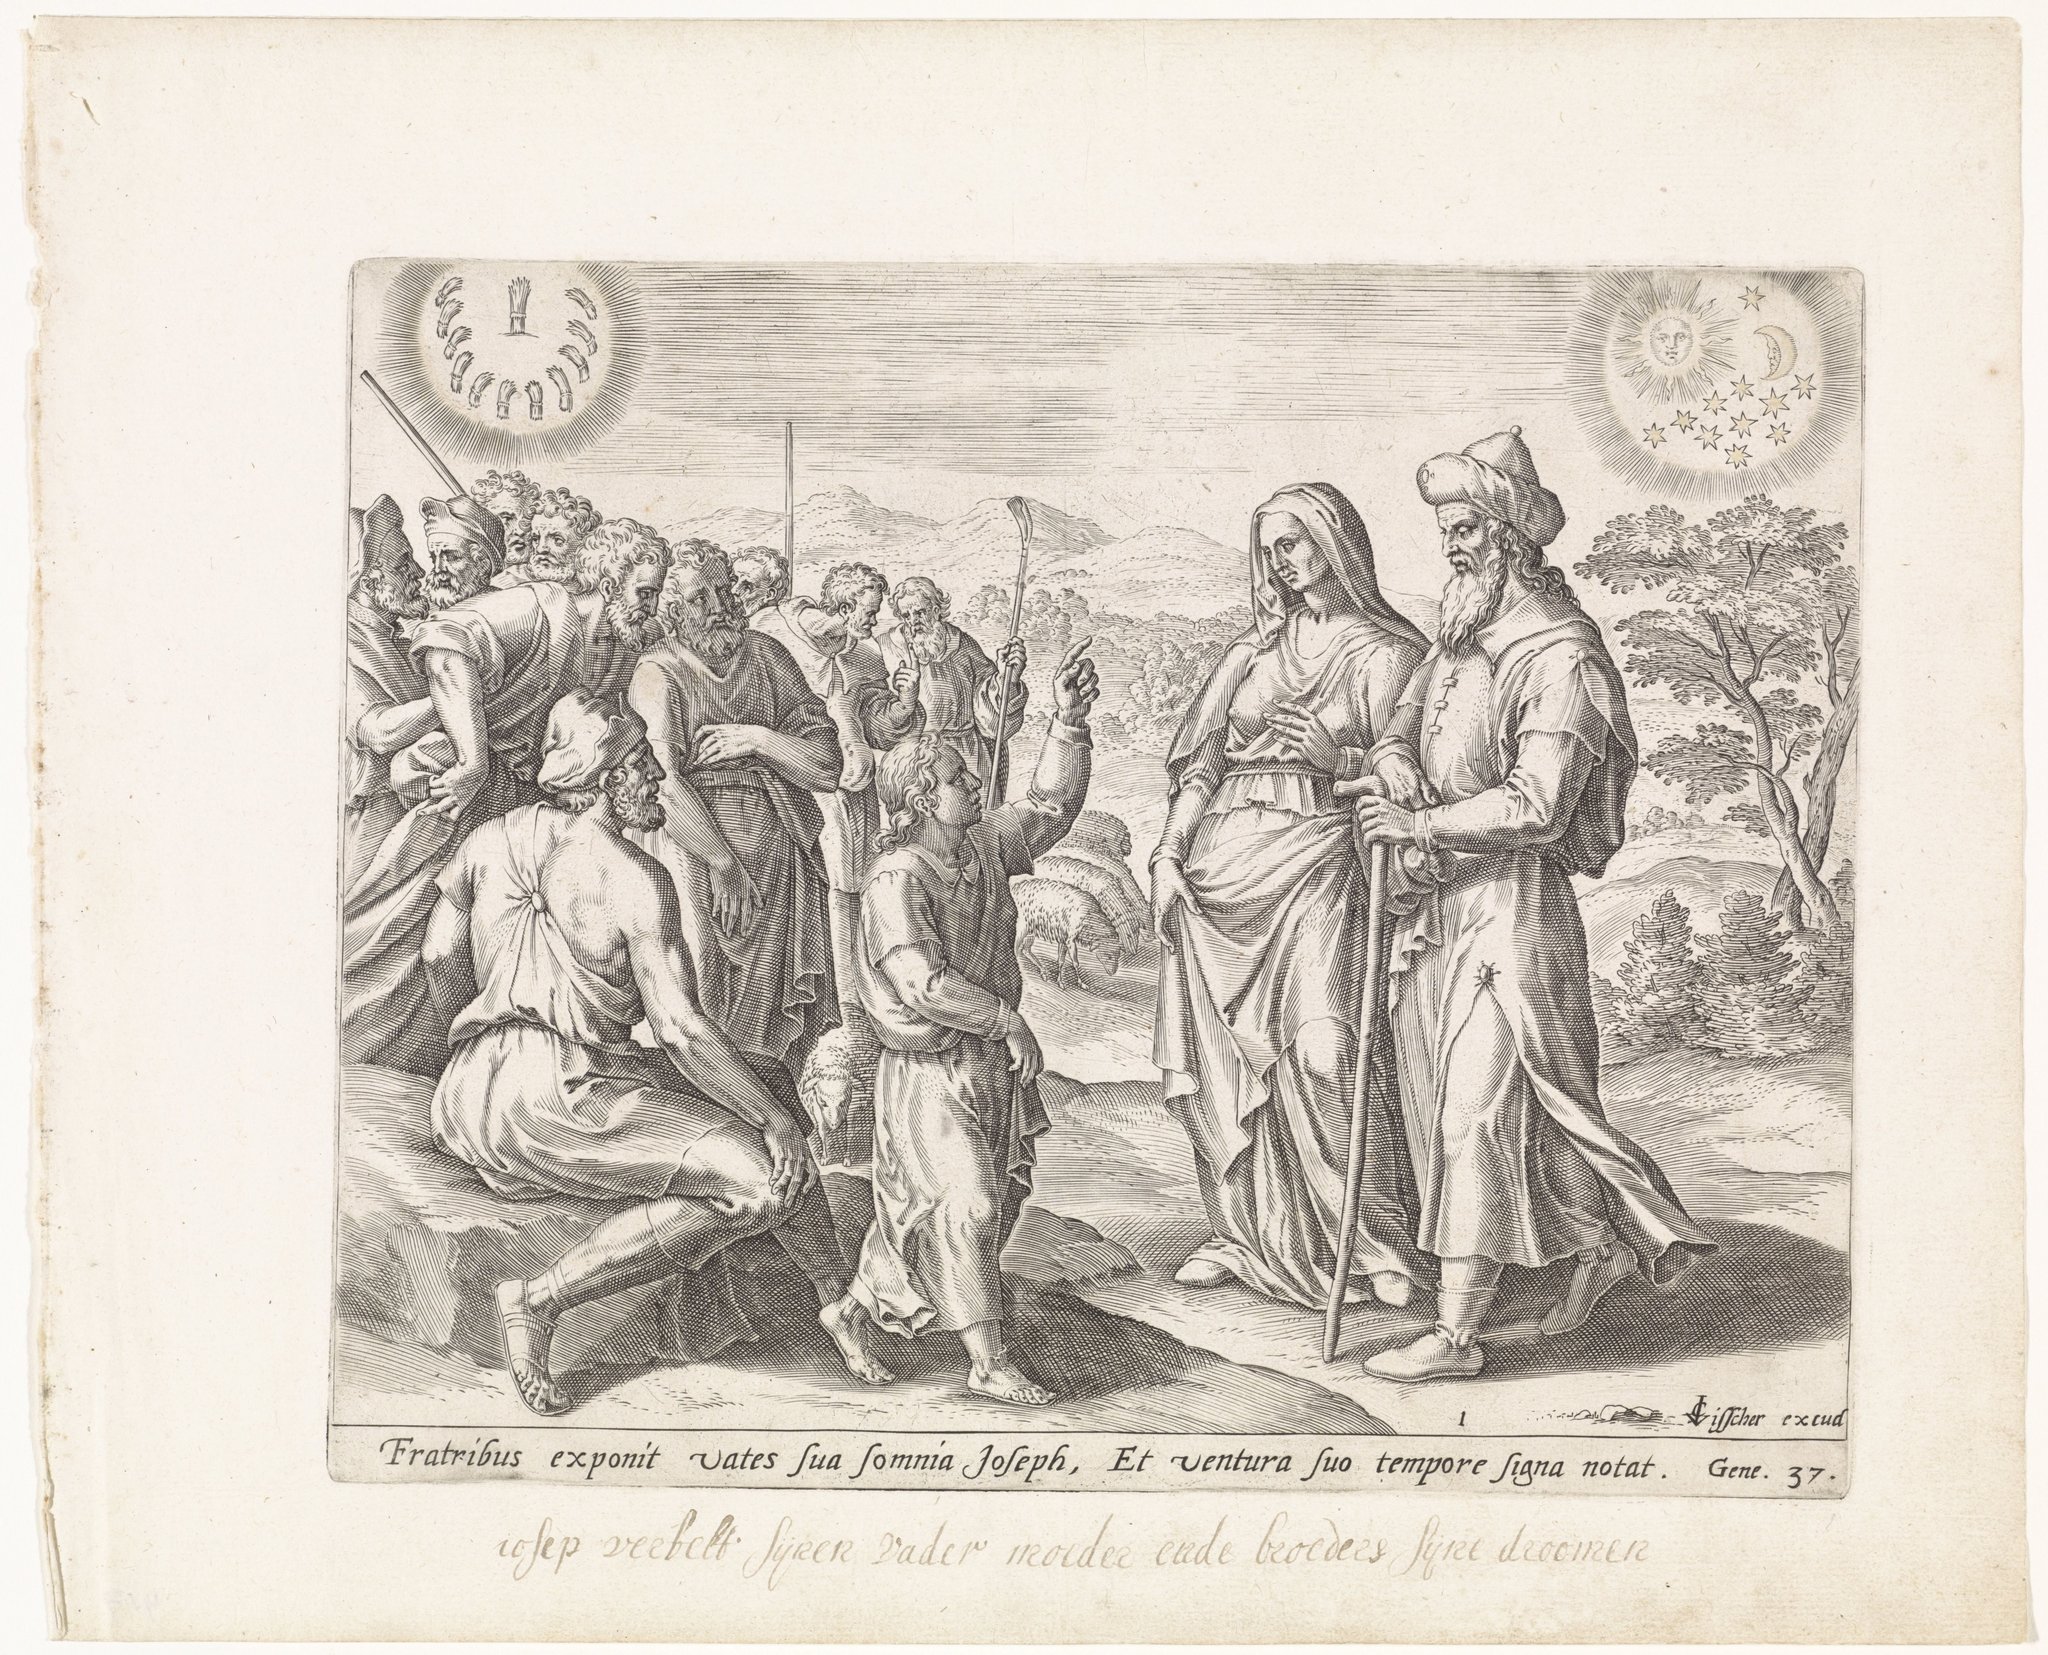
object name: print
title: Theatrum biblicum (...)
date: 1579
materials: paper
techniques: engraving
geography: amsterdam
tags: joseph relating his dreams (the two dreams combined)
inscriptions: collector's mark: Lugt 2228, inscription: ‘iosep vertelt sijner vader moeder ende broeders sijne droomen’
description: Jozef legt zijn dromen uit aan zijn ouders en zijn broers. Linksboven de droom van de korenschoven, waarbij de korenschoven van zijn broers voor Jozefs korenschoof buigen. Rechtsboven de droom, waarin de zon, man en elf sterren zich voor Jozef buigen. Onder de voorstelling een verwijzing in het Latijn naar de Bijbeltekst in Gen. 37.